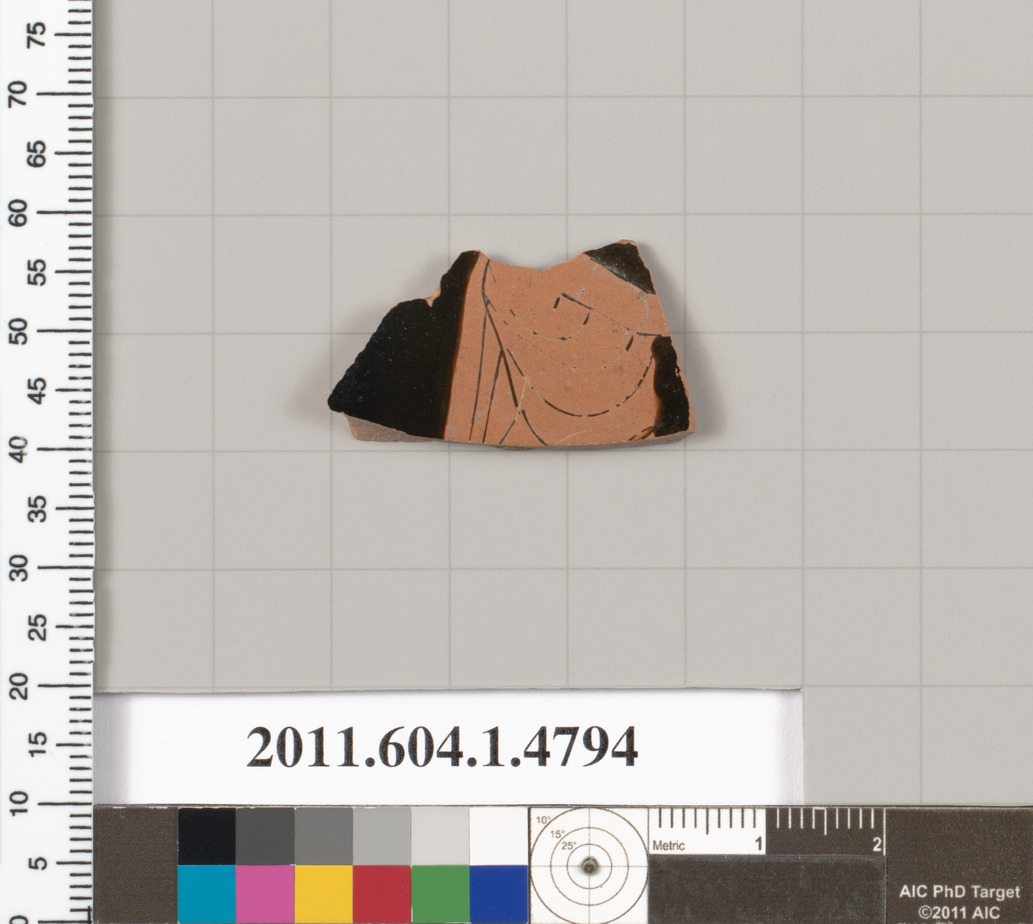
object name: kylix fragment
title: Terracotta fragment of a kylix (drinking cup)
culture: greek, attic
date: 475-451 BCE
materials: terracotta